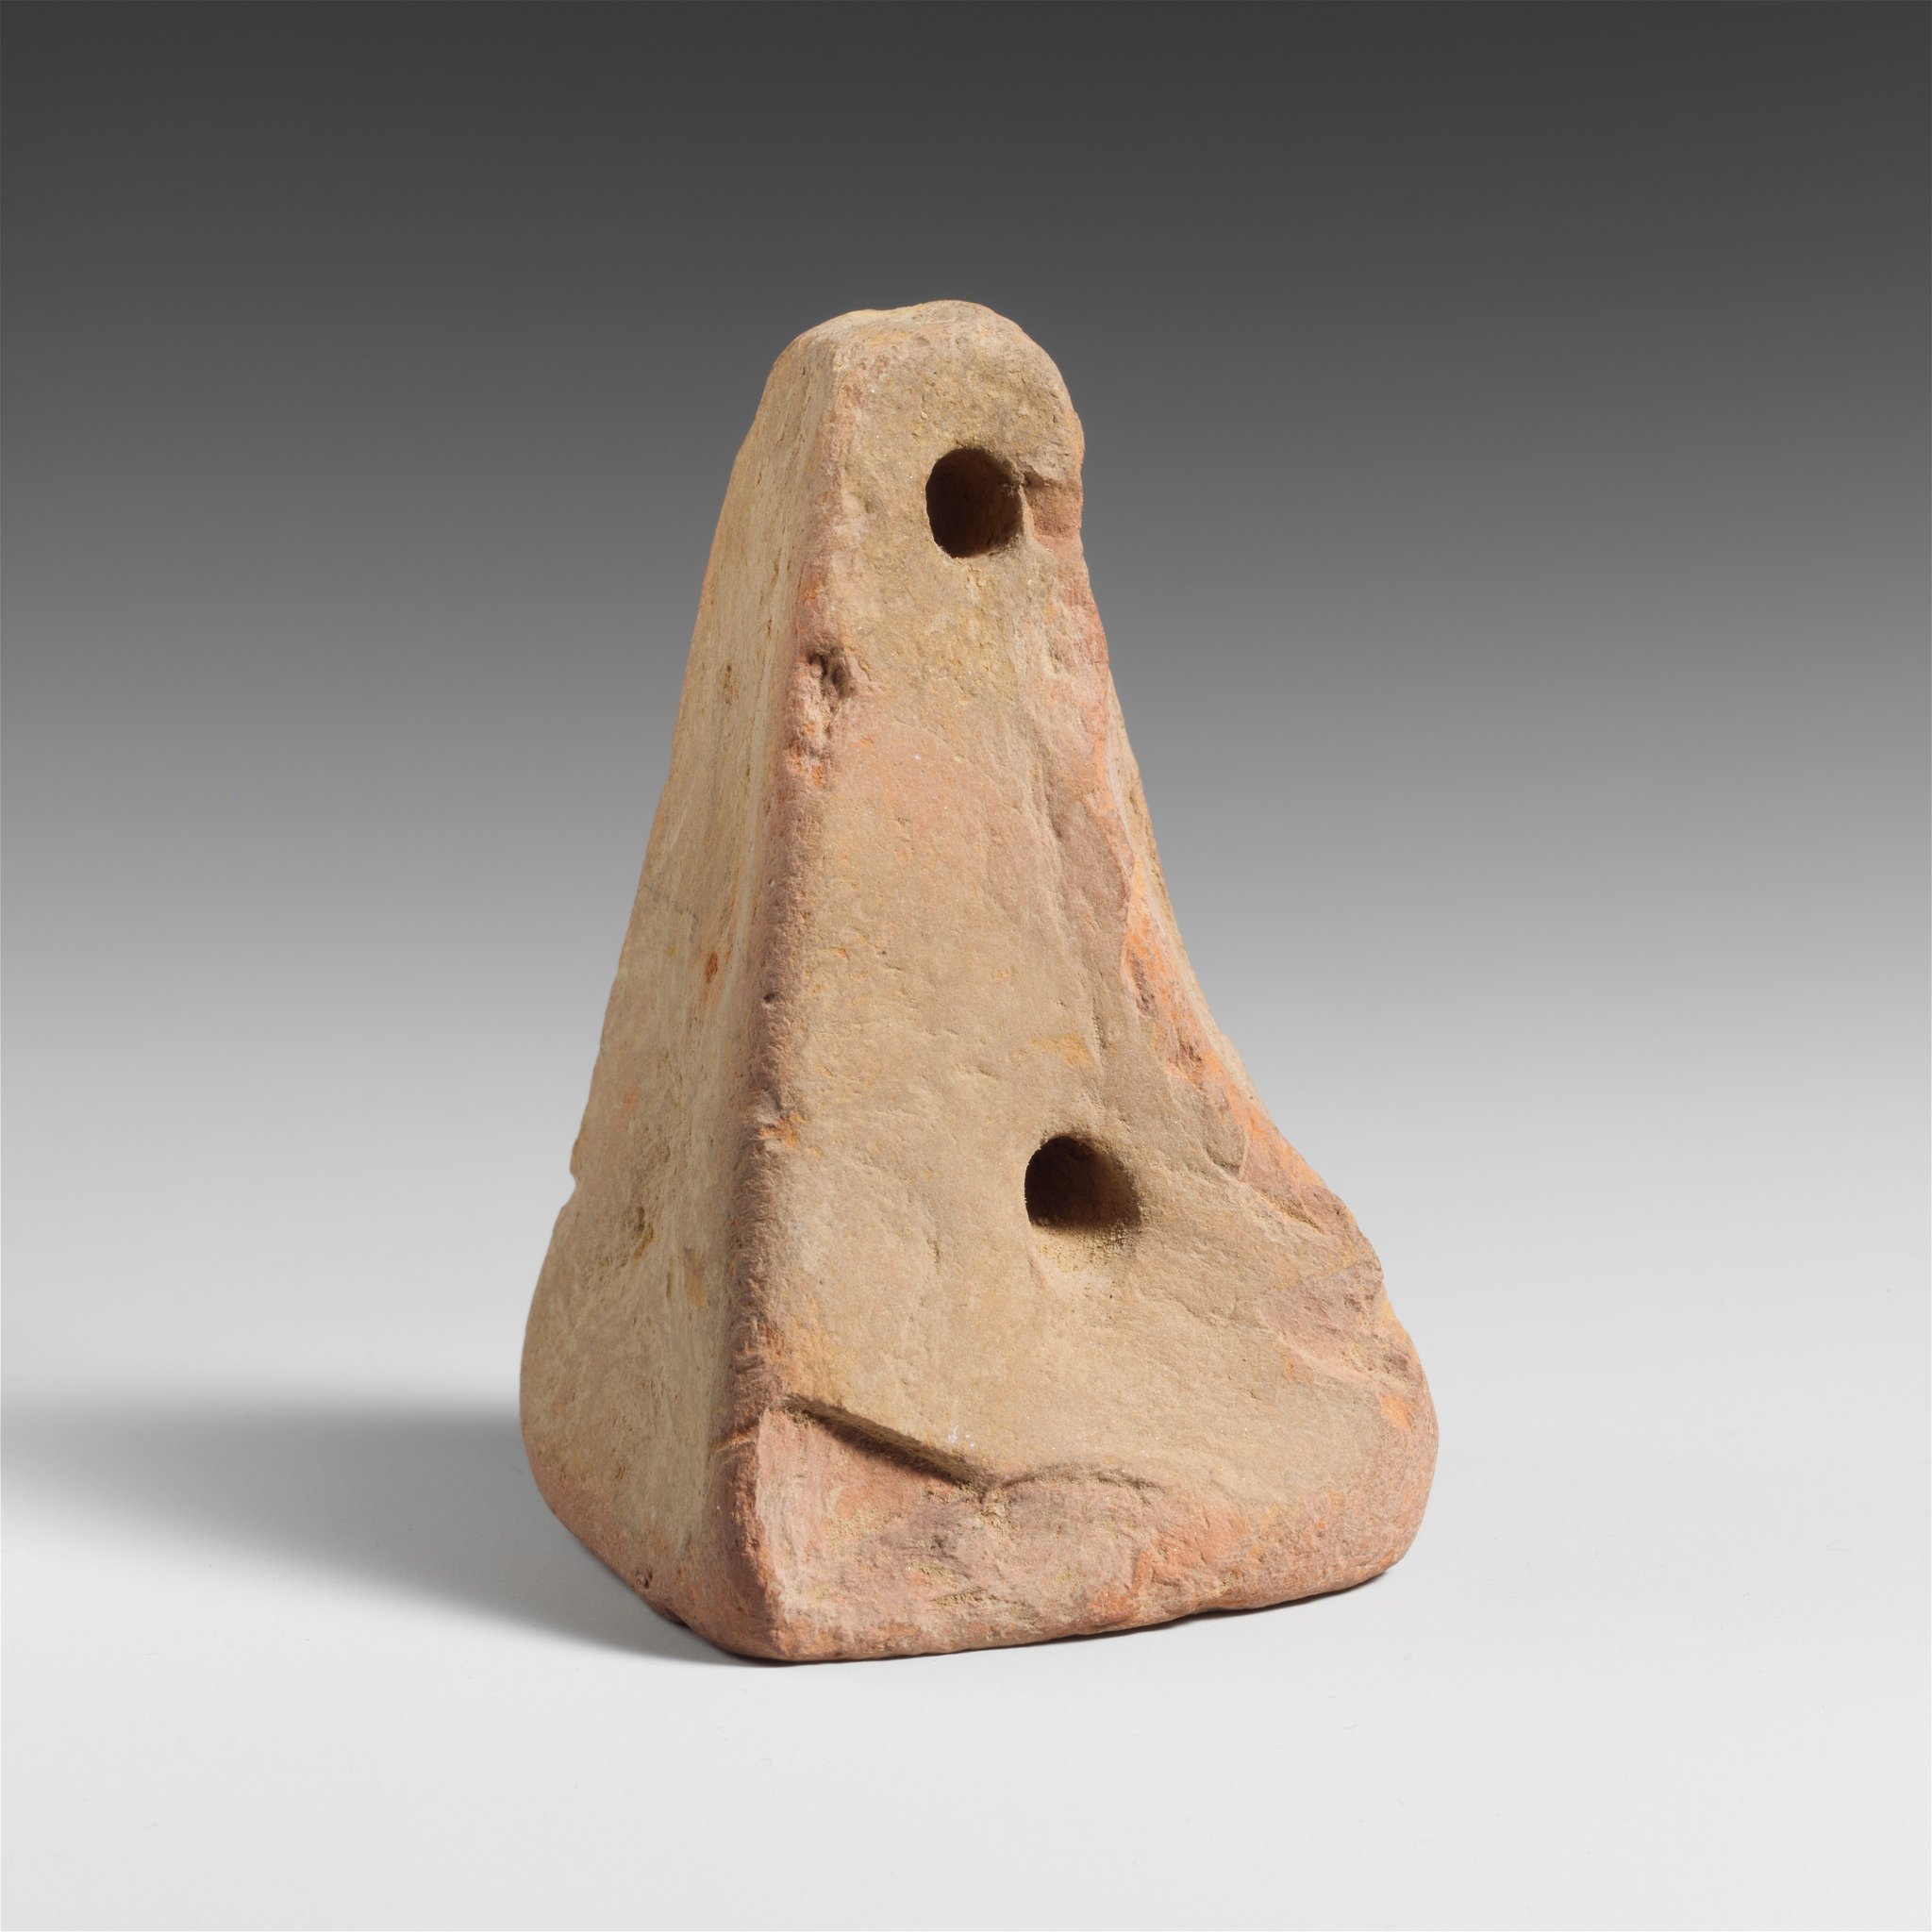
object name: loom weight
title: Terracotta loom weight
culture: lydian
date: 501-600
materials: terracotta